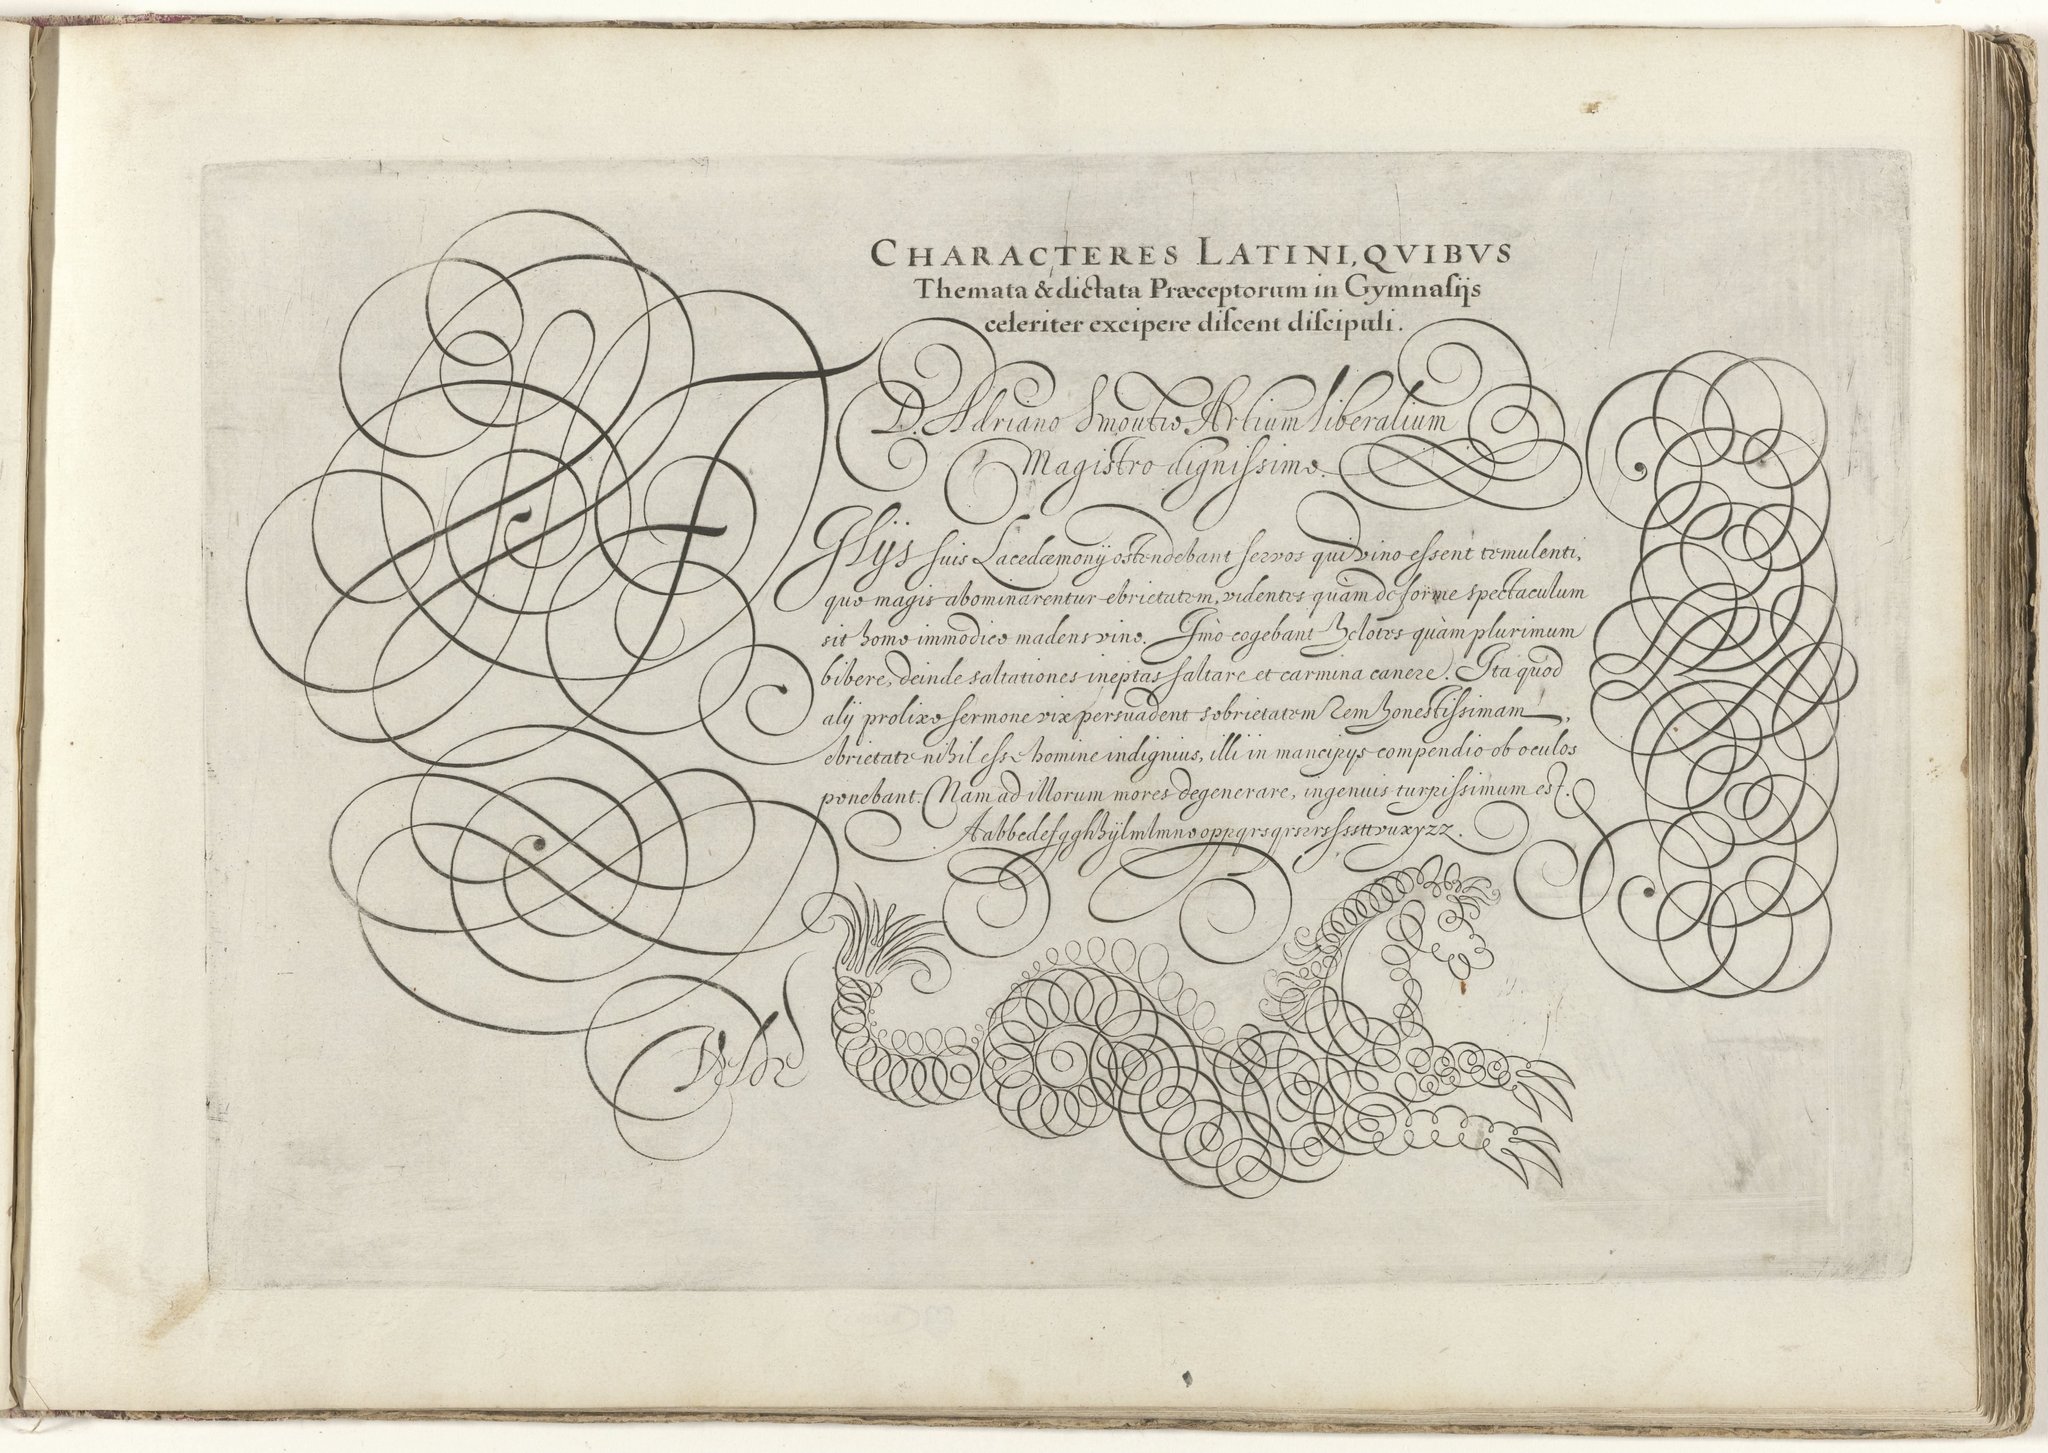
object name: album leaf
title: Schrijfvoorbeeld: Characteres Latini (...)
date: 1608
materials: paper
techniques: engraving, intaglio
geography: amsterdam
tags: sea-horse, hippocamp, 'hippocampus', (horse/fish) (mythological hybrid monster), calligraphy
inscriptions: collector's mark: Lugt 2228, collector's mark: Lugt 2760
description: Schrijfvoorbeeld met de aanhef: Characteres Latini ... en een dedicatie in twee regels: D. Adriano Smoutio artium liberalium magistro dignissimo. Daaronder een initiaal F en acht regels tekst in het Latijn: Filijs suis Lacedaemony ... De tekst eindigt met een onderkastalfabet in dezelfde hand. Rechts en links krulwerk. Onderaan een (zee)paard in krulwerk. De prent maakt deel uit van een album.